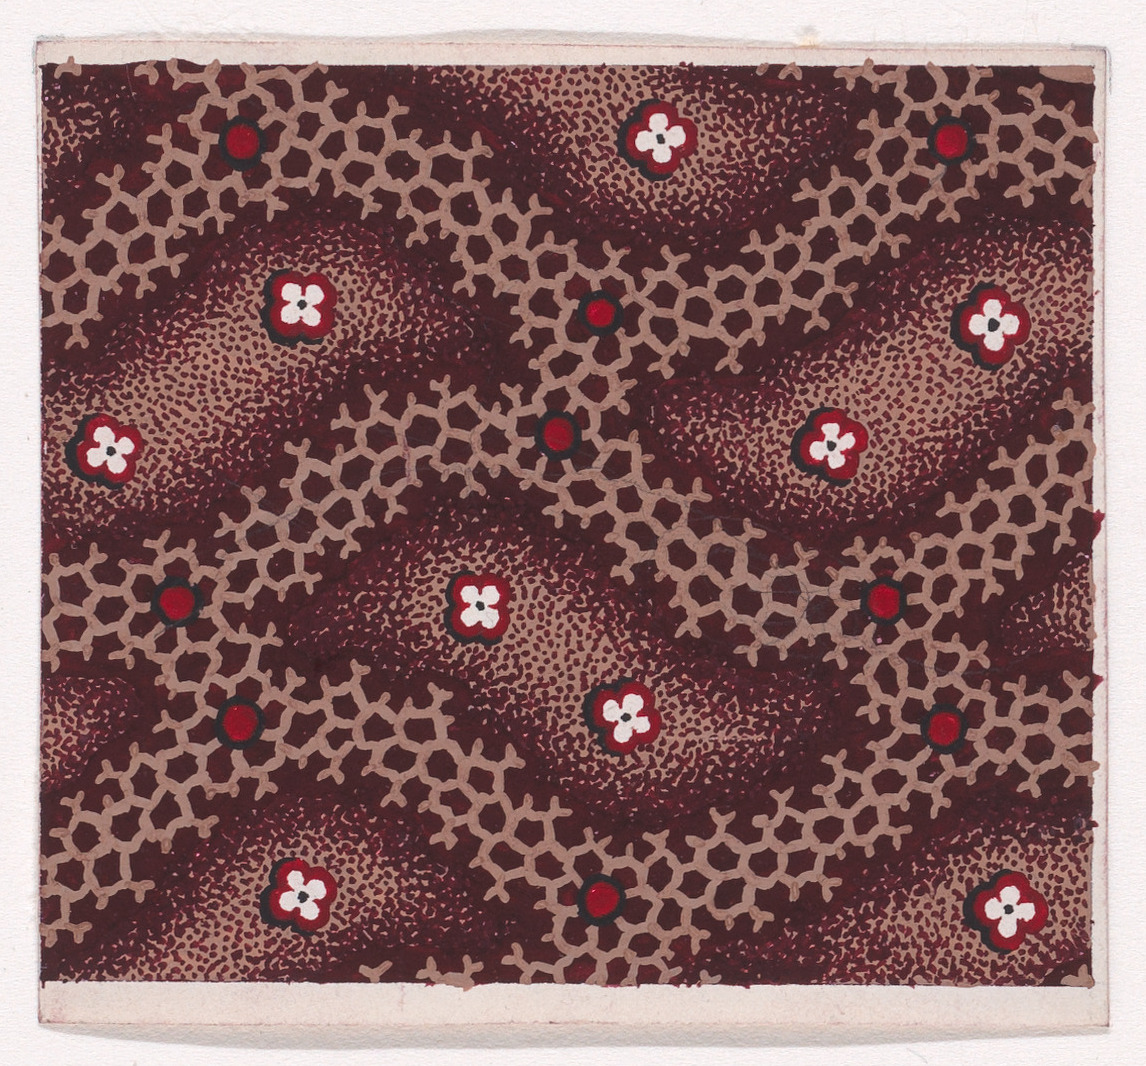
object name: drawing ornament architecture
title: Textile Design with Alternating Stylized Leaves with Rosettes over a Background of a Honeycomb Pattern with Pearls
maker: anonymous, alsatian, 19th century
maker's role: artist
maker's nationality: alsatian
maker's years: 1800-1900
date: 1840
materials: gouache